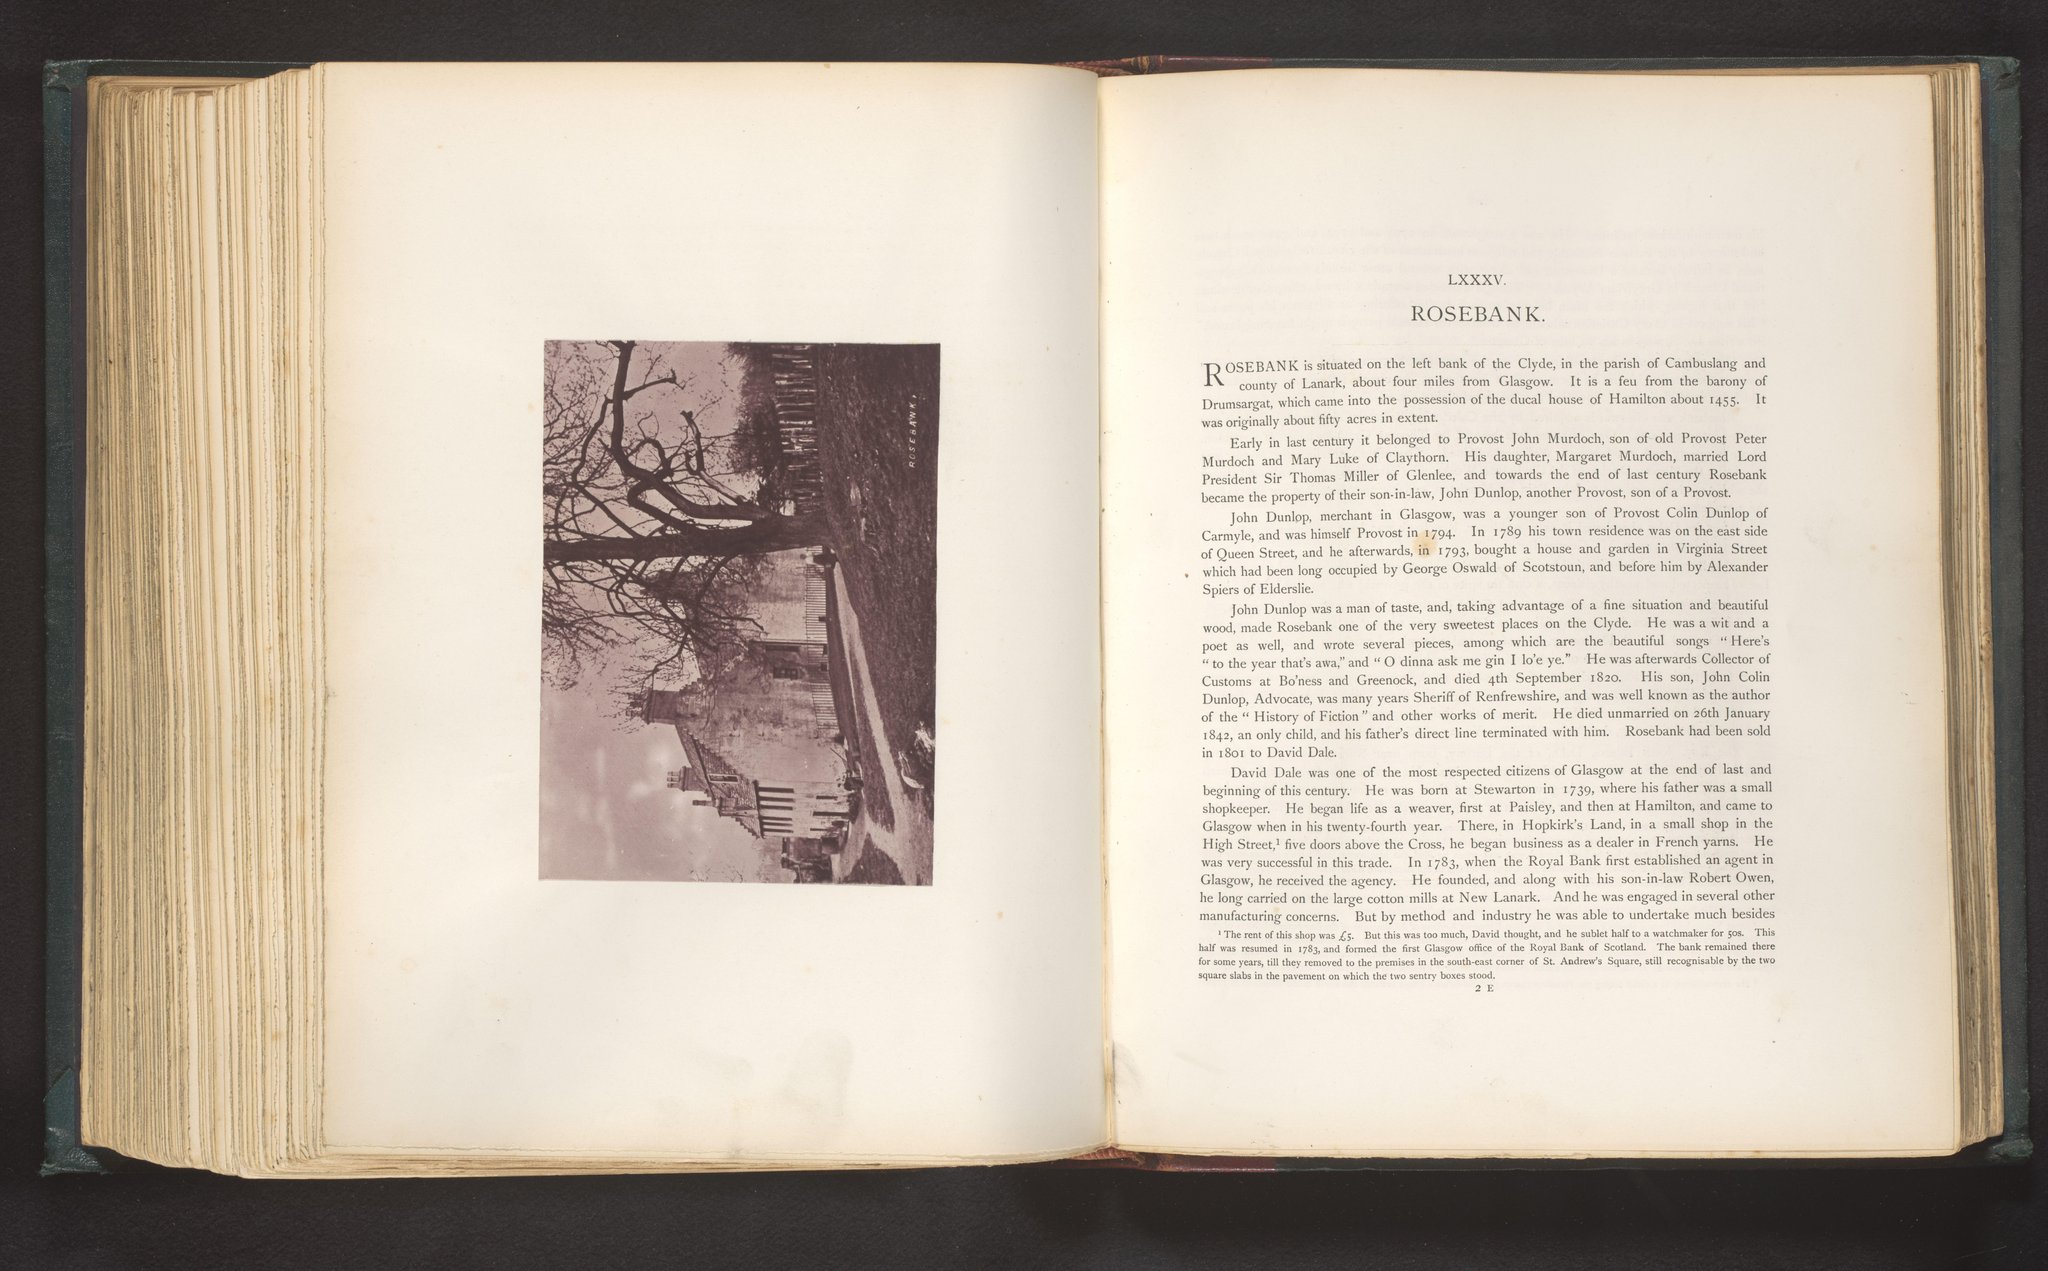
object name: photograph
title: Rosebank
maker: thomas annan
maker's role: fotograaf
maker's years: 1829-1887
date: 1868-1878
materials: paper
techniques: carbon print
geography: scotland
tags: rural housing, e.g. country-house, villa, cottage, façade (of house or building)